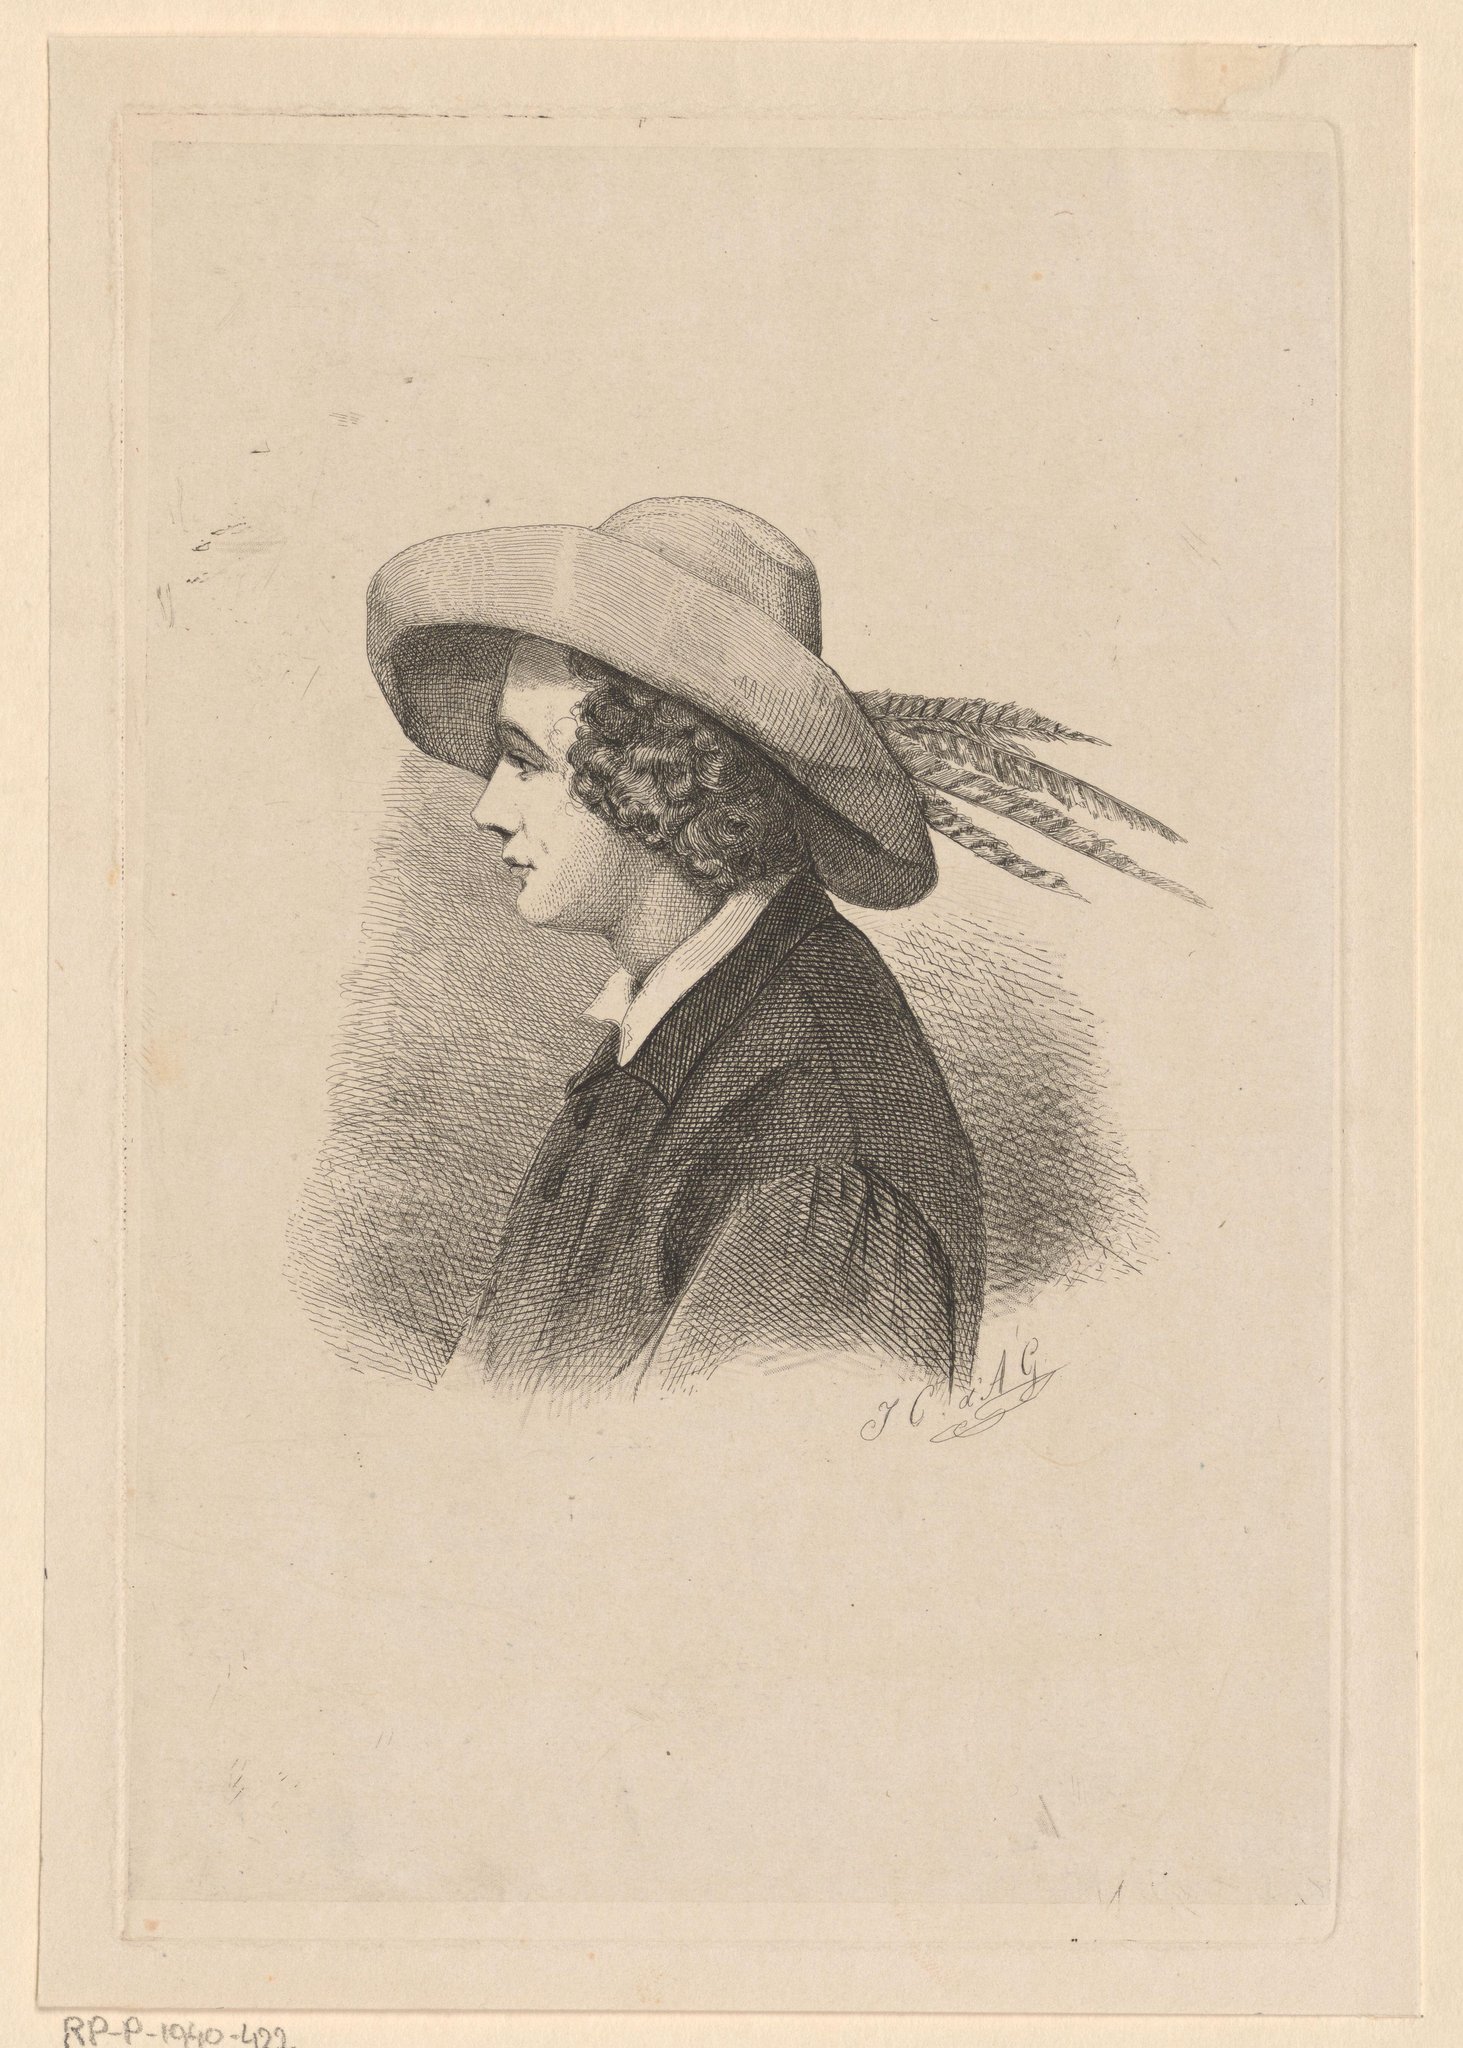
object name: print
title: Portret van Martinus Antonius Kuytenbrouwer jr.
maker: johannes christiaan d arnaud gerkens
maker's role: draughtsman, print maker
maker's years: 1823-1892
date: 1831-1892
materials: paper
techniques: etching, roulette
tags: painter, martinus antonius kuytenbrouwer jr., historical persons, portrait, self-portrait of painter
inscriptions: collector's mark: Lugt 2228, collector's mark: Lugt 2760